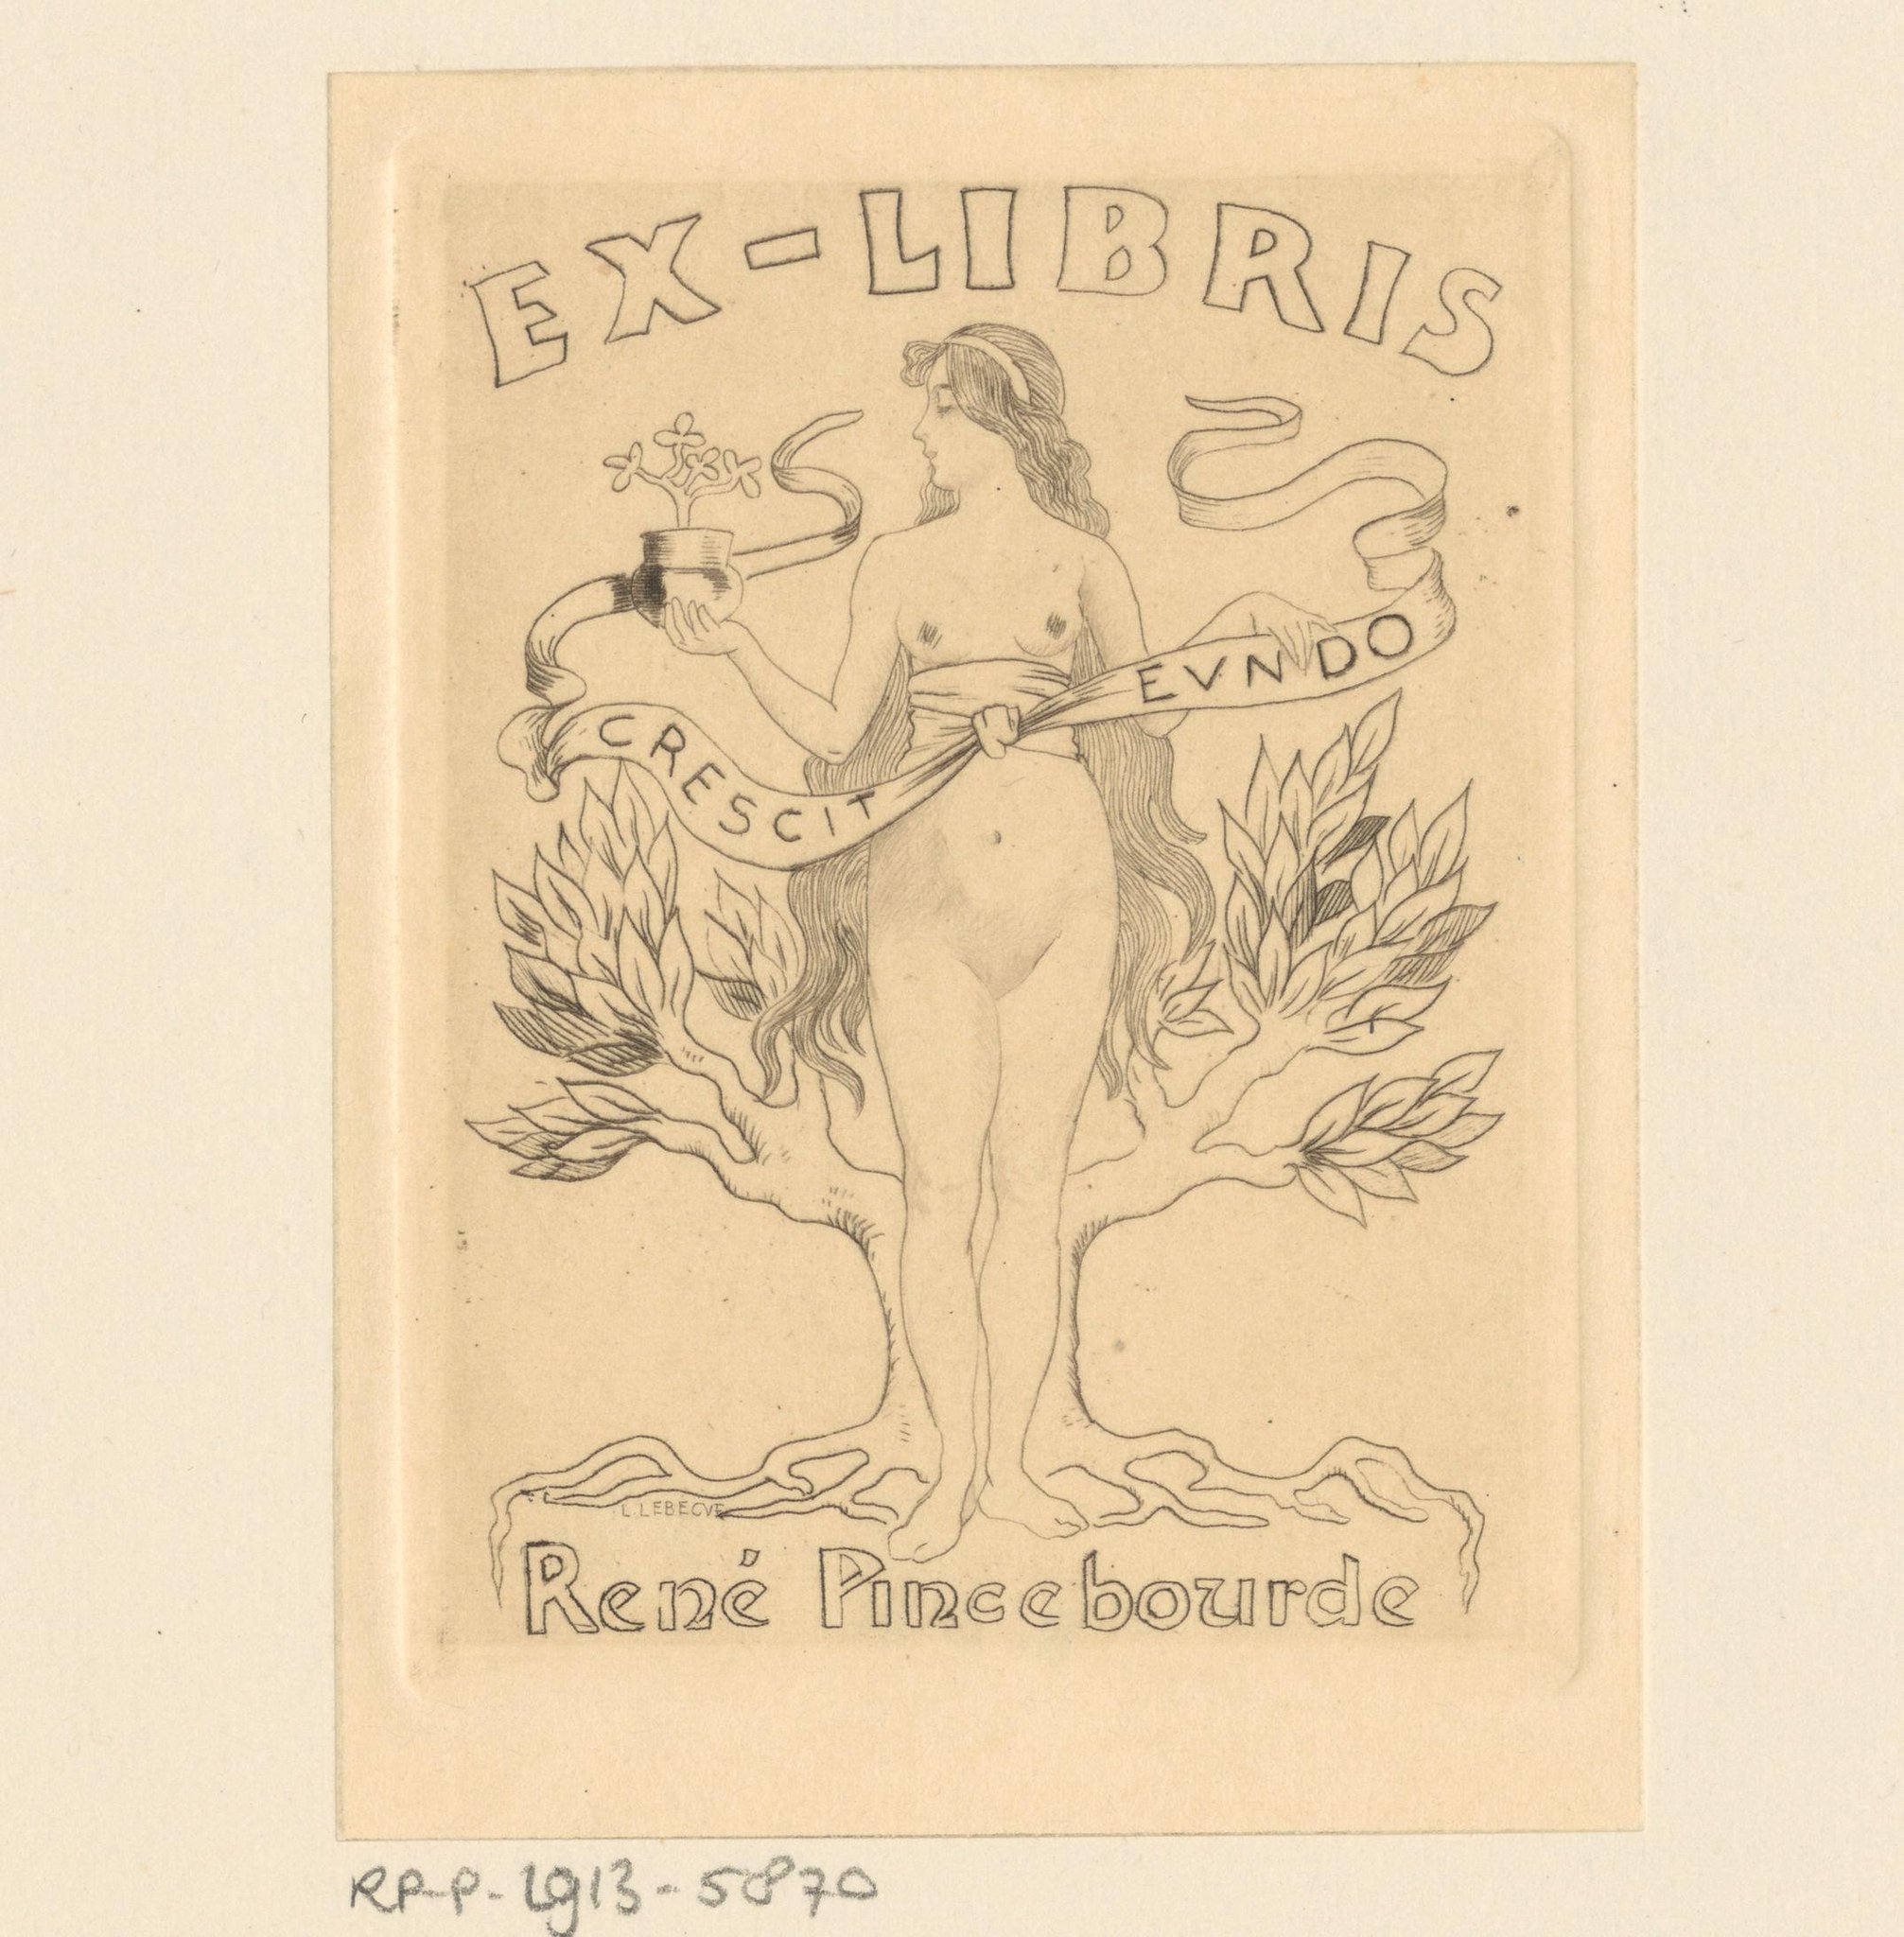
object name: bookplate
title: Crescit enudo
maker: léon lebègue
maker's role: graveur, illustrator, lithograaf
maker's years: 1863-1944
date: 1873-1889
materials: paper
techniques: drypoint, etching, intaglio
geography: france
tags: publisher, woman (showing herself) undressed, quasi-nude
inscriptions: collector's mark: Lugt 2233, collector's mark: Lugt 2760